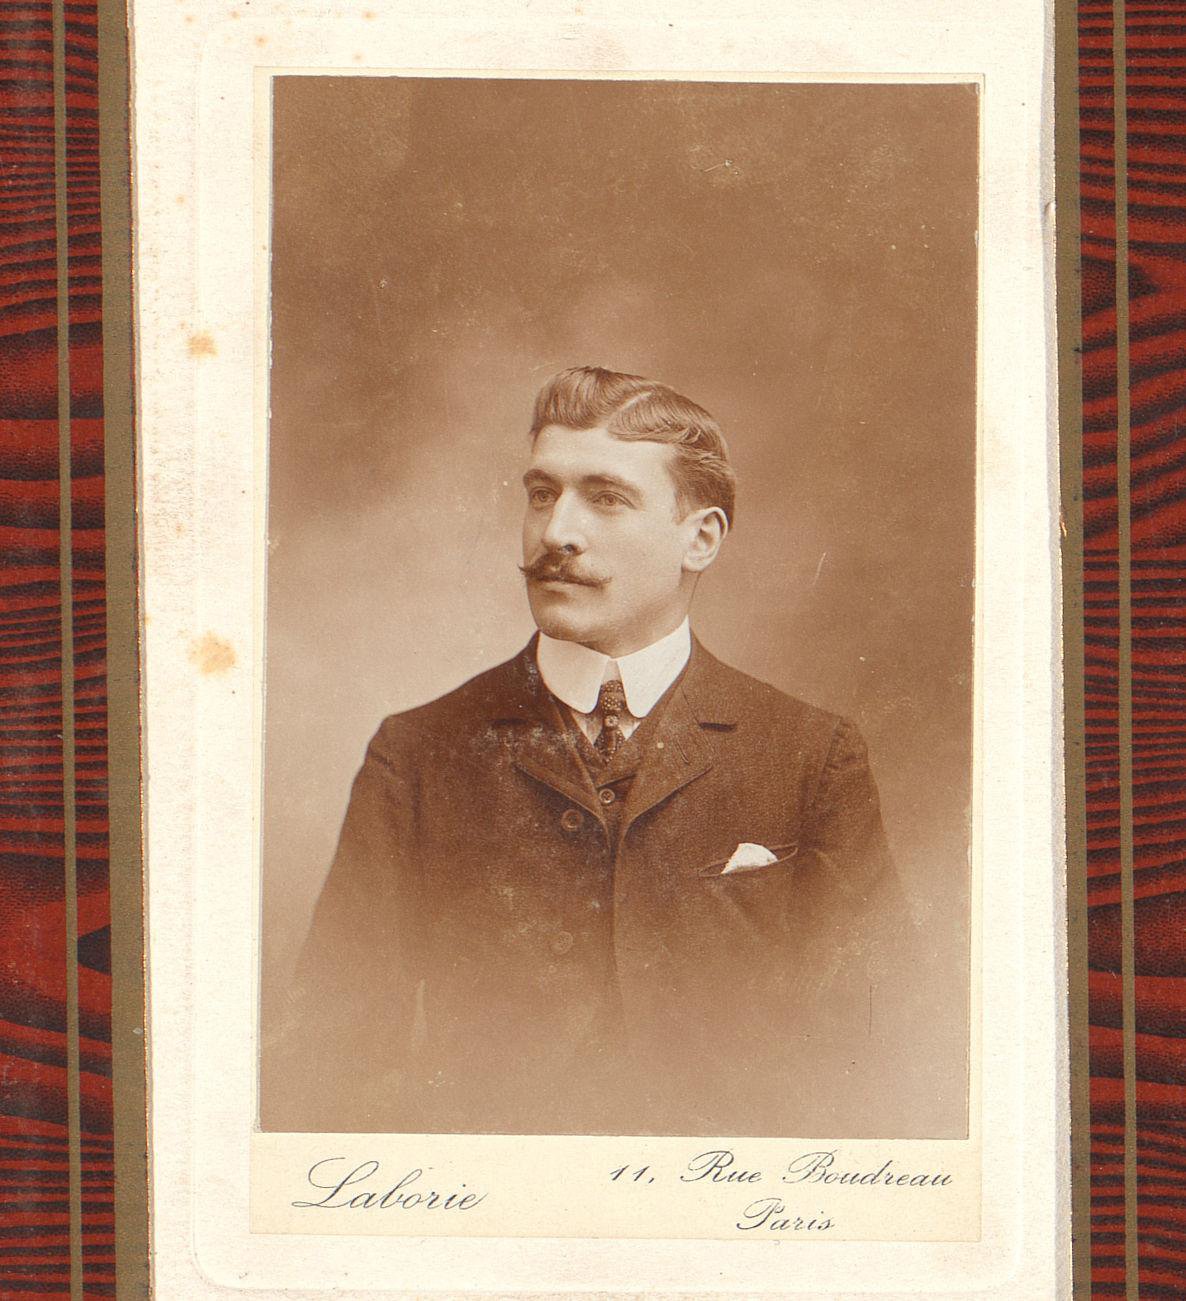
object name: photograph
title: Portret van een man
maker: g.d. laborie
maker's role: fotograaf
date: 1860-1920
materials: cardboard, photographic support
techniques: daylight paper print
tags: adult man, historical persons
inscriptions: inscription: ‘Photographe/ de l'opera/ Laborie/ 11.R.Boudreau Paris’